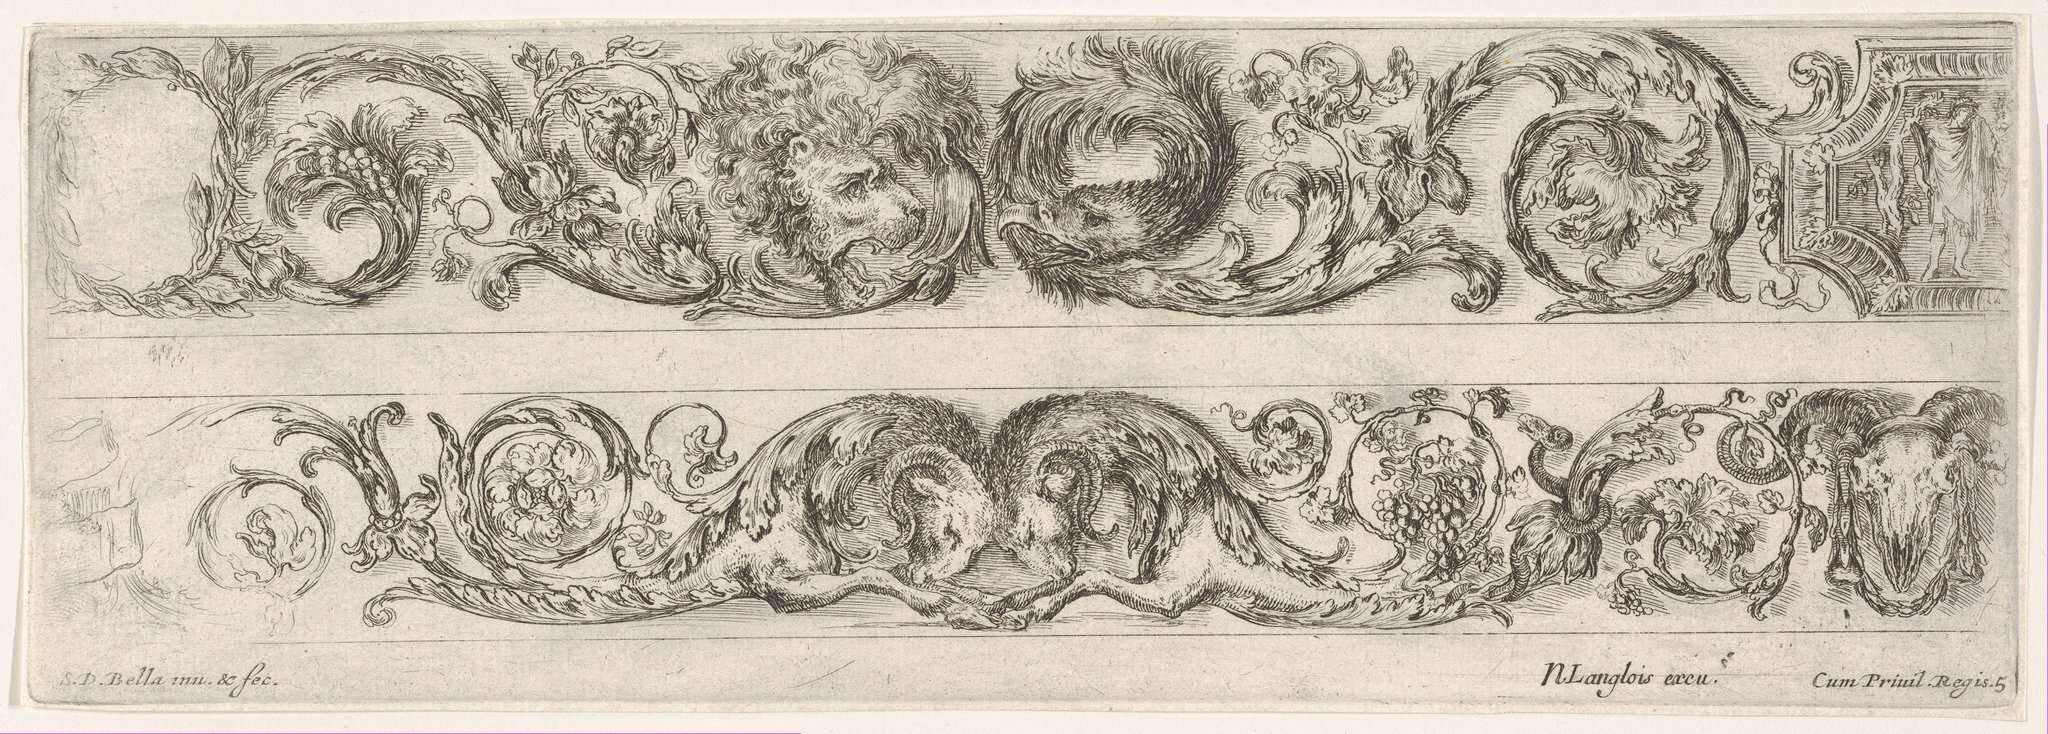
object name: print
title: Two Frieze Designs with Acanthus Scrolls combined with a Lion and Eagle on top and Two Rams below, plate 5 from "Decorative friezes and foliage" (Ornamenti di fregi e fogliami)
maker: stefano della bella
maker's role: artist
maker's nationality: italian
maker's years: 1610-1664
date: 1645-1650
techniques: etching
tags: eagles,lions,rams,acanthus